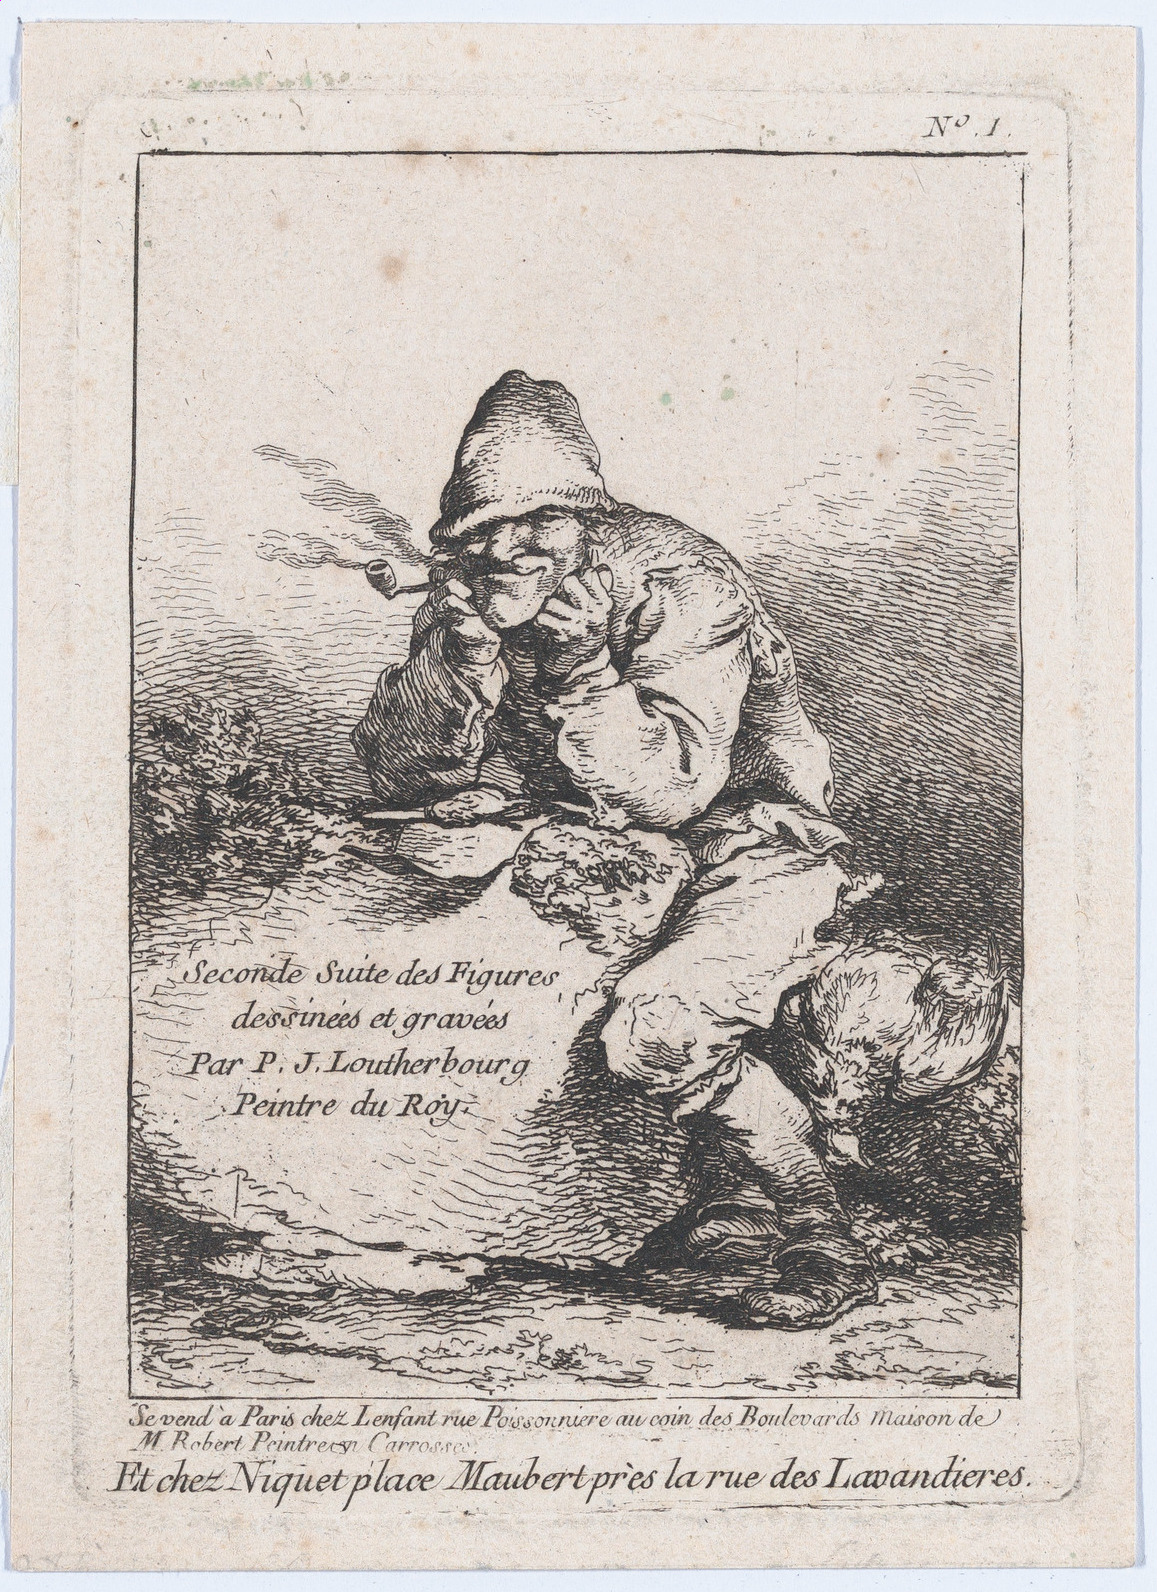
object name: print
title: Seated Man Smoking a Pipe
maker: philippe jacques de loutherbourg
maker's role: artist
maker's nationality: french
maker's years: 1740-1812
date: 1755-1771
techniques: etching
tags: men,smoking